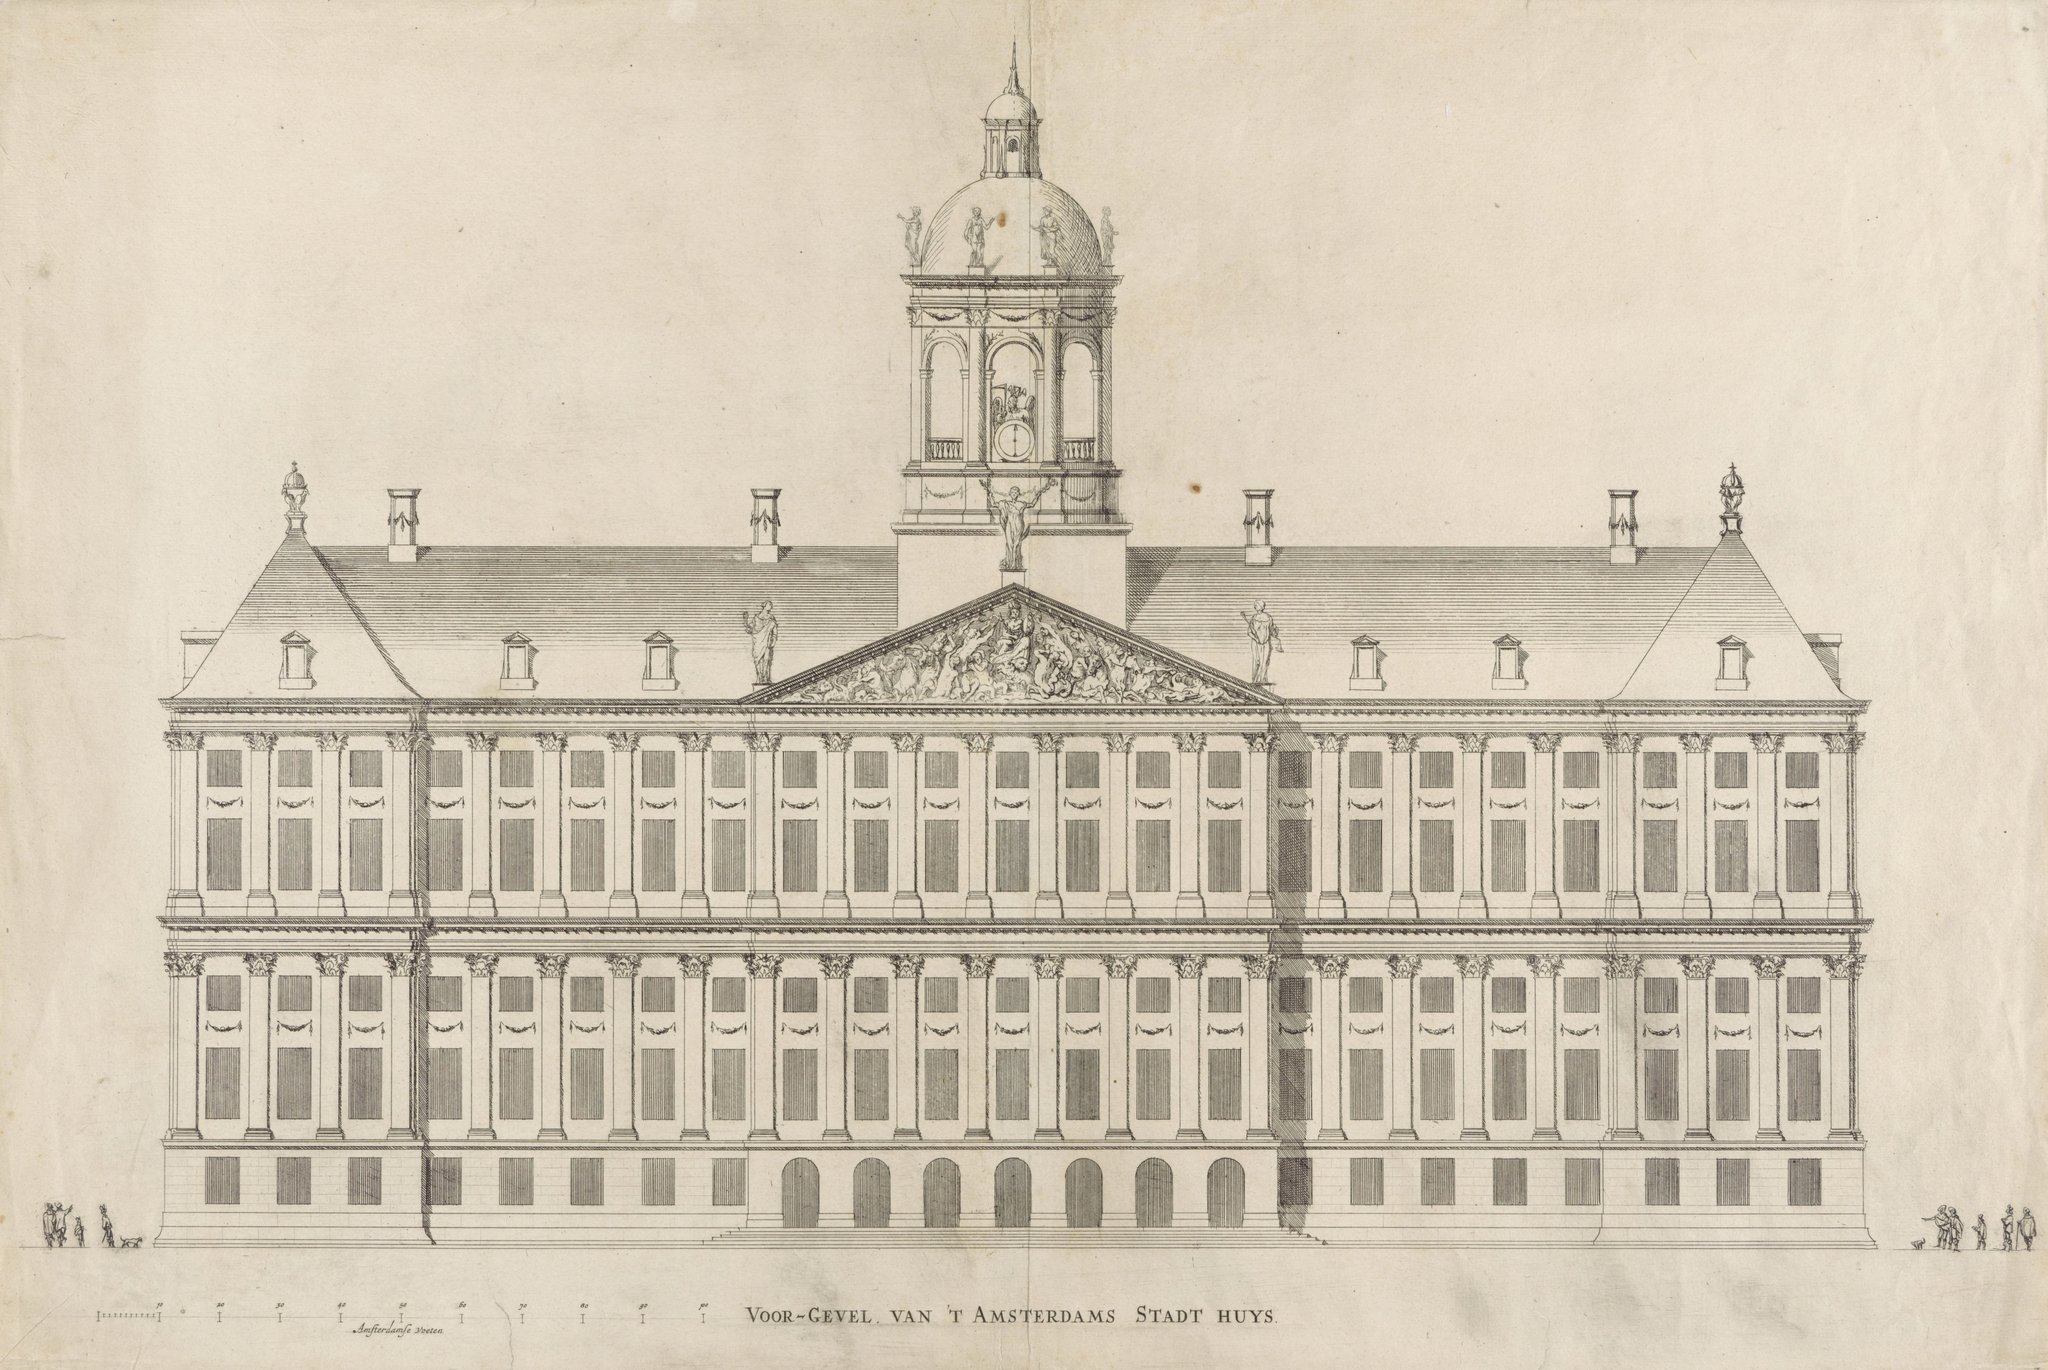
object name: print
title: Voor-Gevel van 'T Amsterdams Stadt Huys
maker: hubert quellinus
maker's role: print maker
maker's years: 1619-1687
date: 1655-1737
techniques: engraving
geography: amsterdam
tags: stadhuis van amsterdam (1655-1808)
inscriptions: collector's mark: Lugt 2228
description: Mogelijk illustratie voor: Hubertus Quellinus en Artus Quellinus, Prima [-secunda] pars praecipuarum effigierum ac ornamentorum, amplissimae curiae Amstelredamensis (...), Amsterdam, 1655 - 1668.